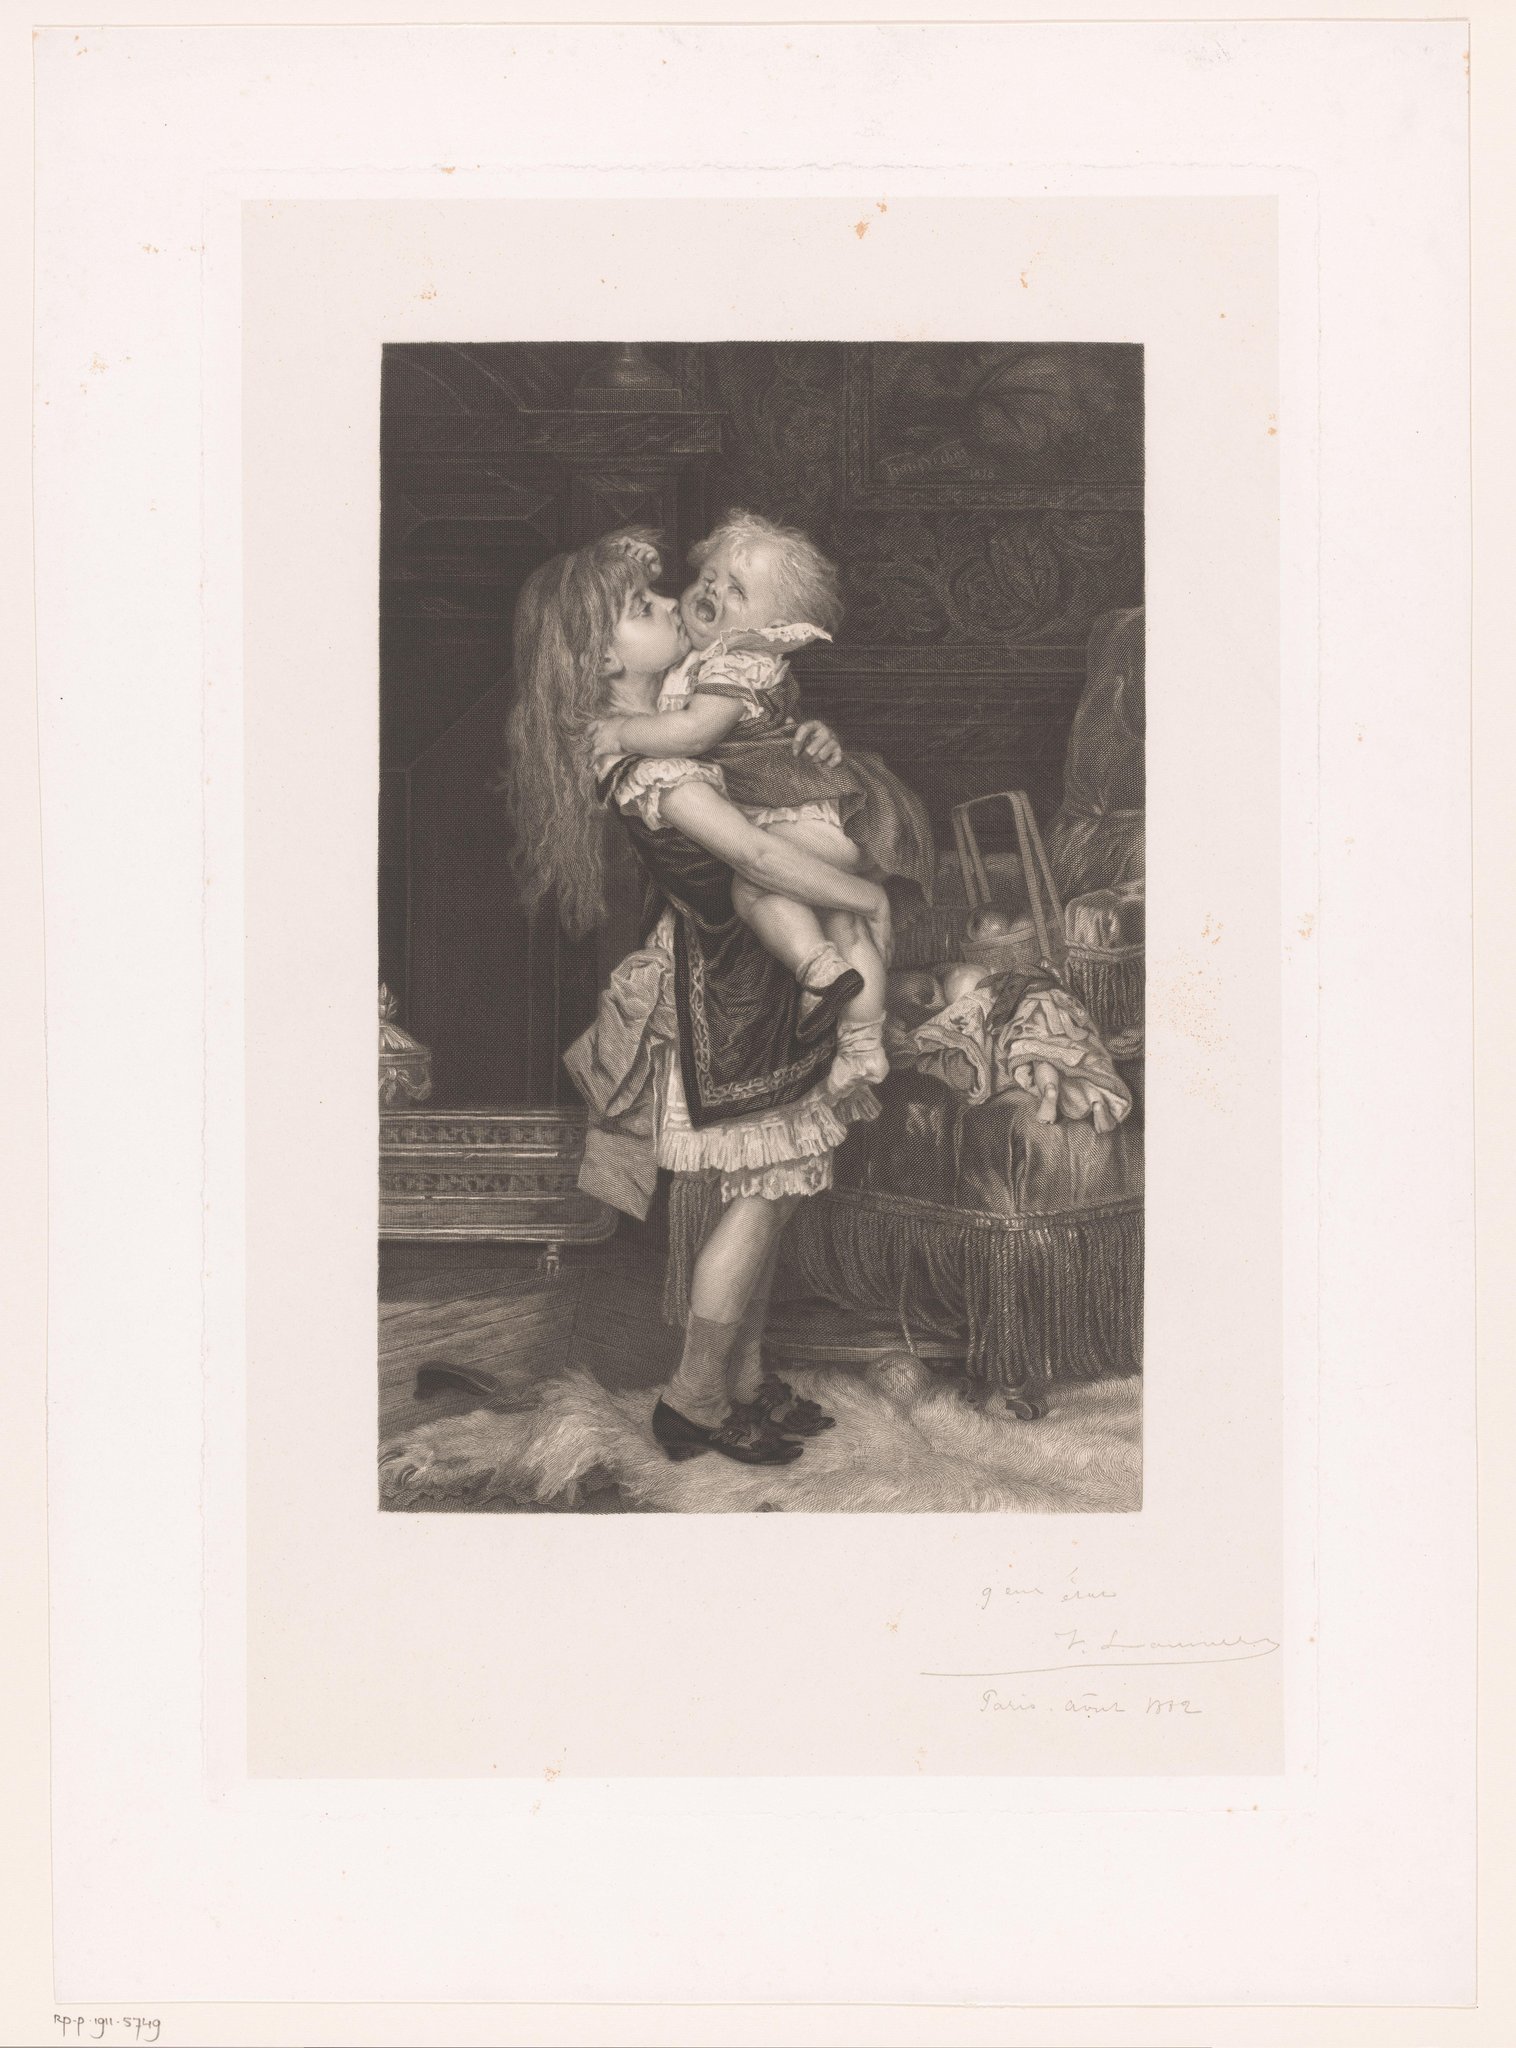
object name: print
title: L'inconsolable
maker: frans lauwers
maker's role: print maker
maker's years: 1854-1931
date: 1808-1882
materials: paper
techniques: etching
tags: consolation, toddler (female)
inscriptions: annotation: ‘9eme état’, collector's mark: Lugt 2228